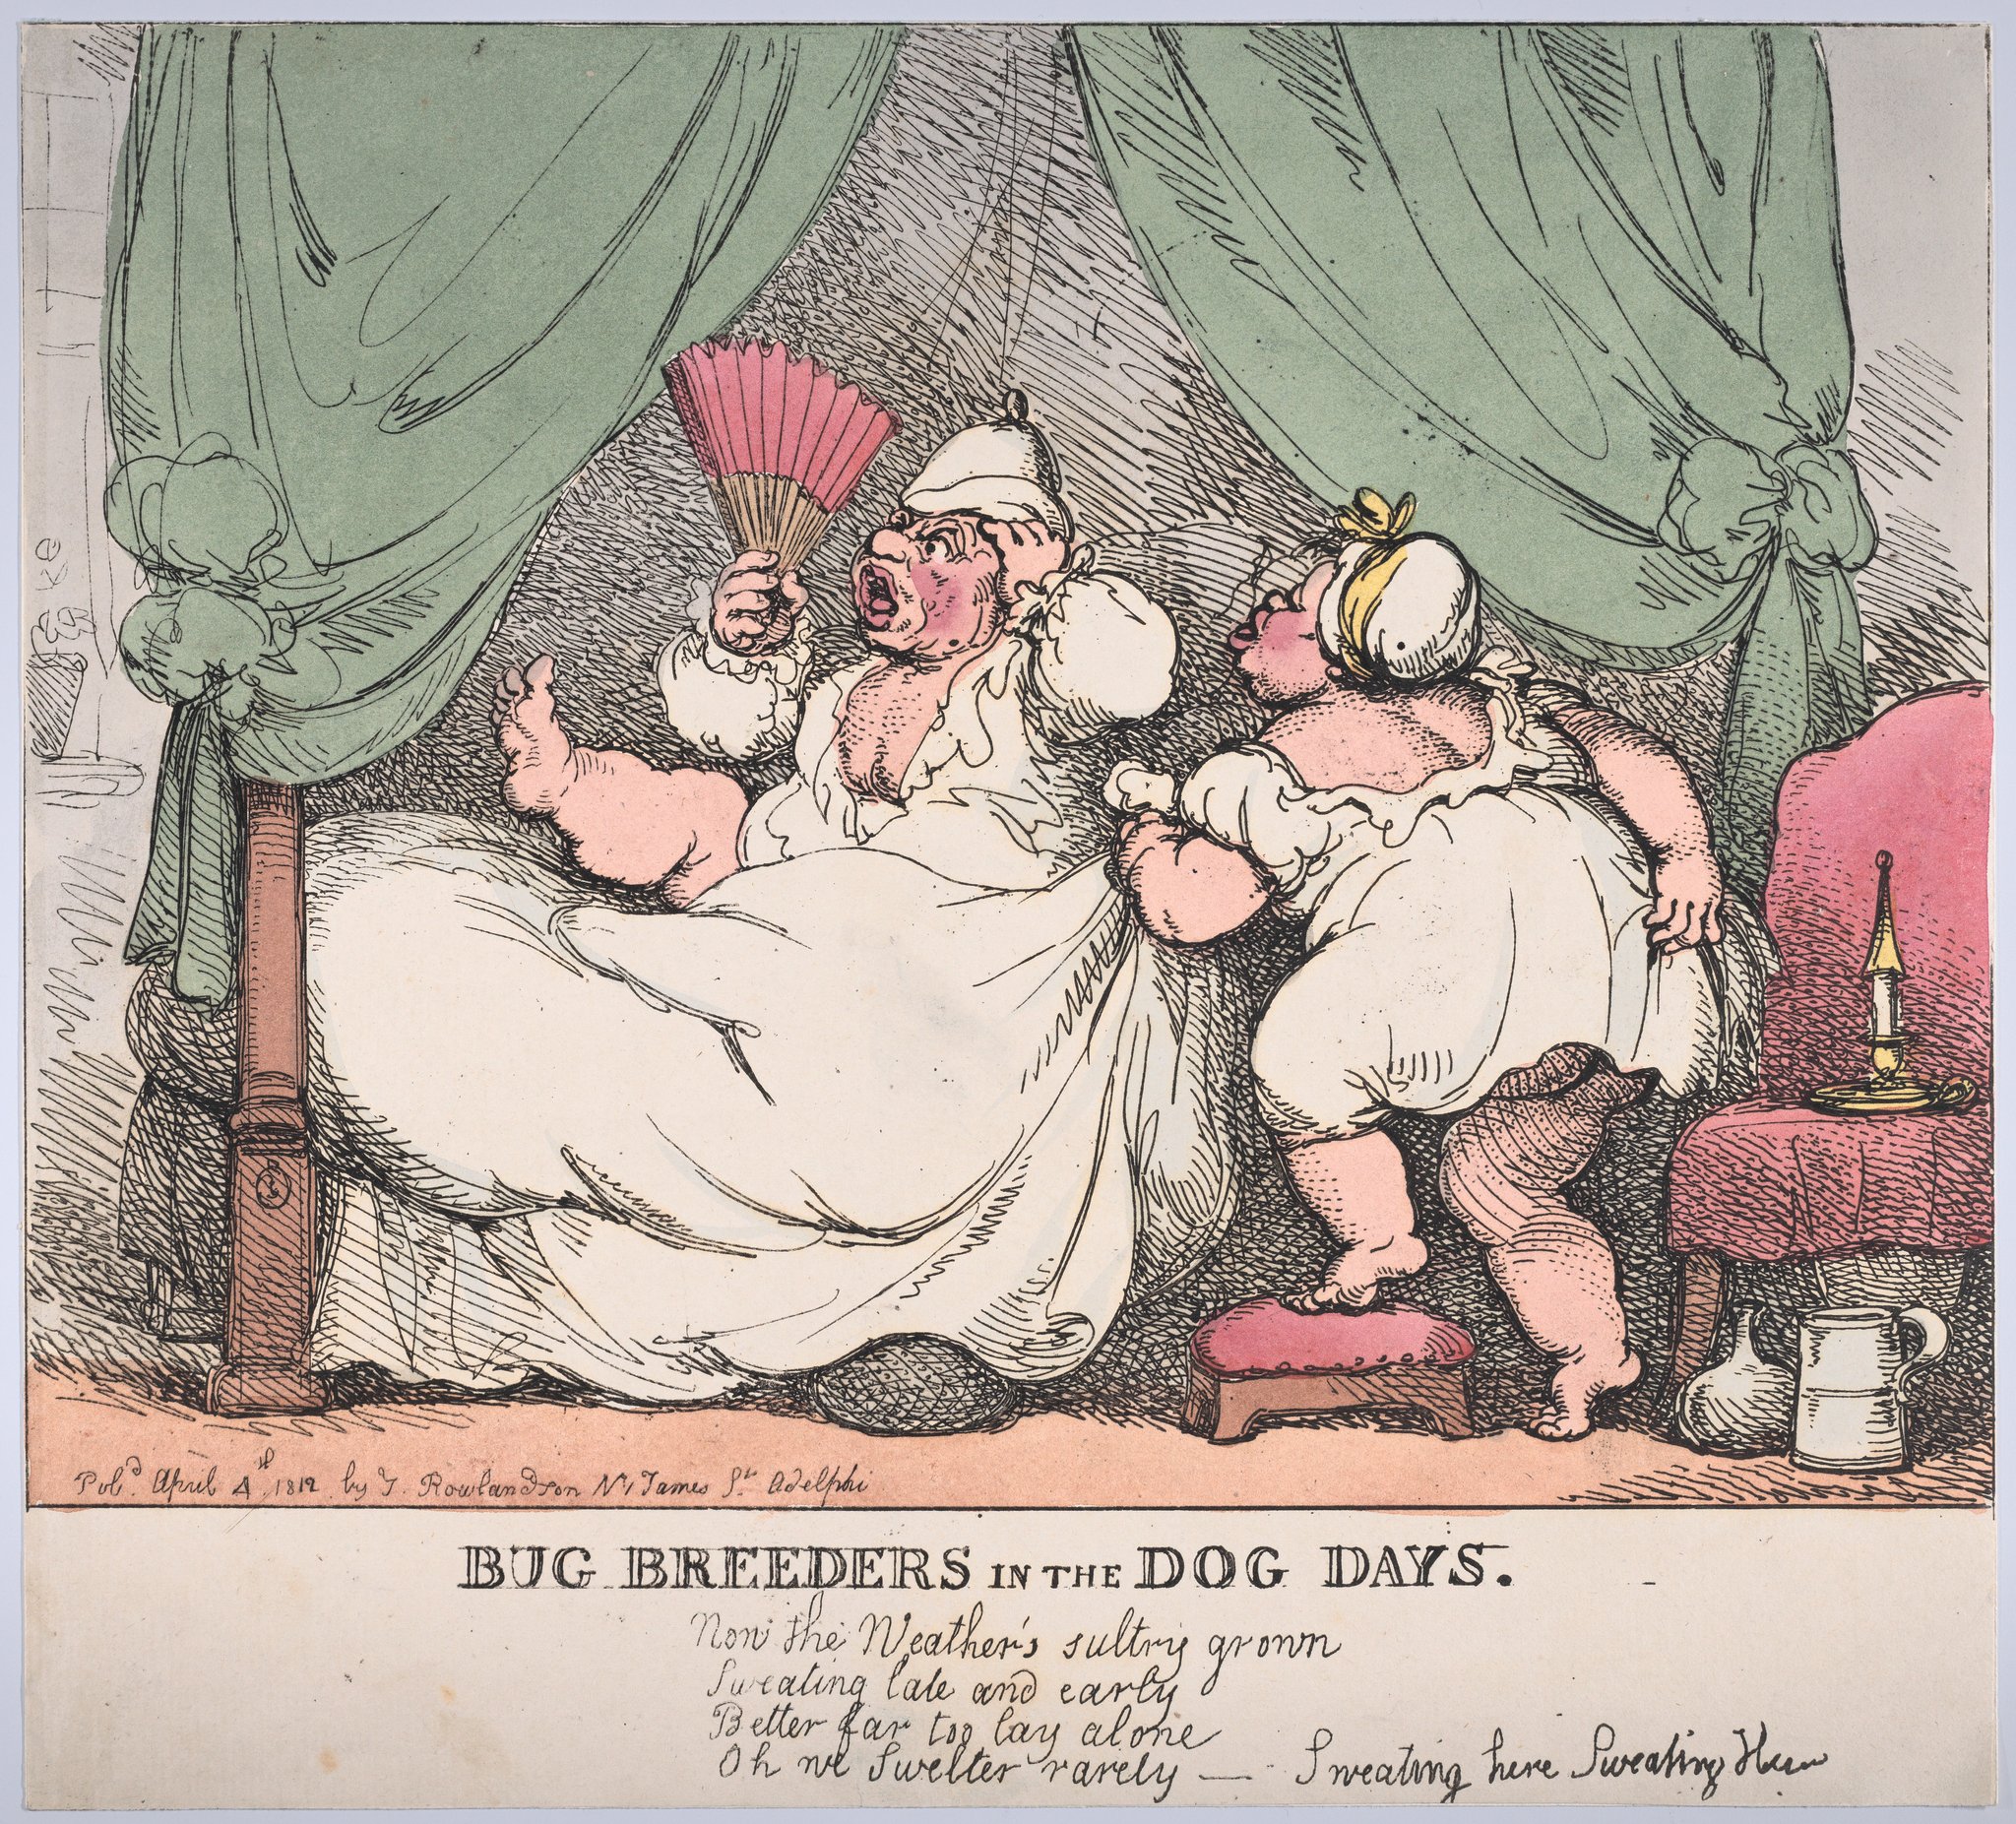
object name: print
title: Bug Breeders in the Dog Days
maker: thomas rowlandson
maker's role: artist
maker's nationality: british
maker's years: 1757-1827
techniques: etching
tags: bedrooms,men,women,caricature